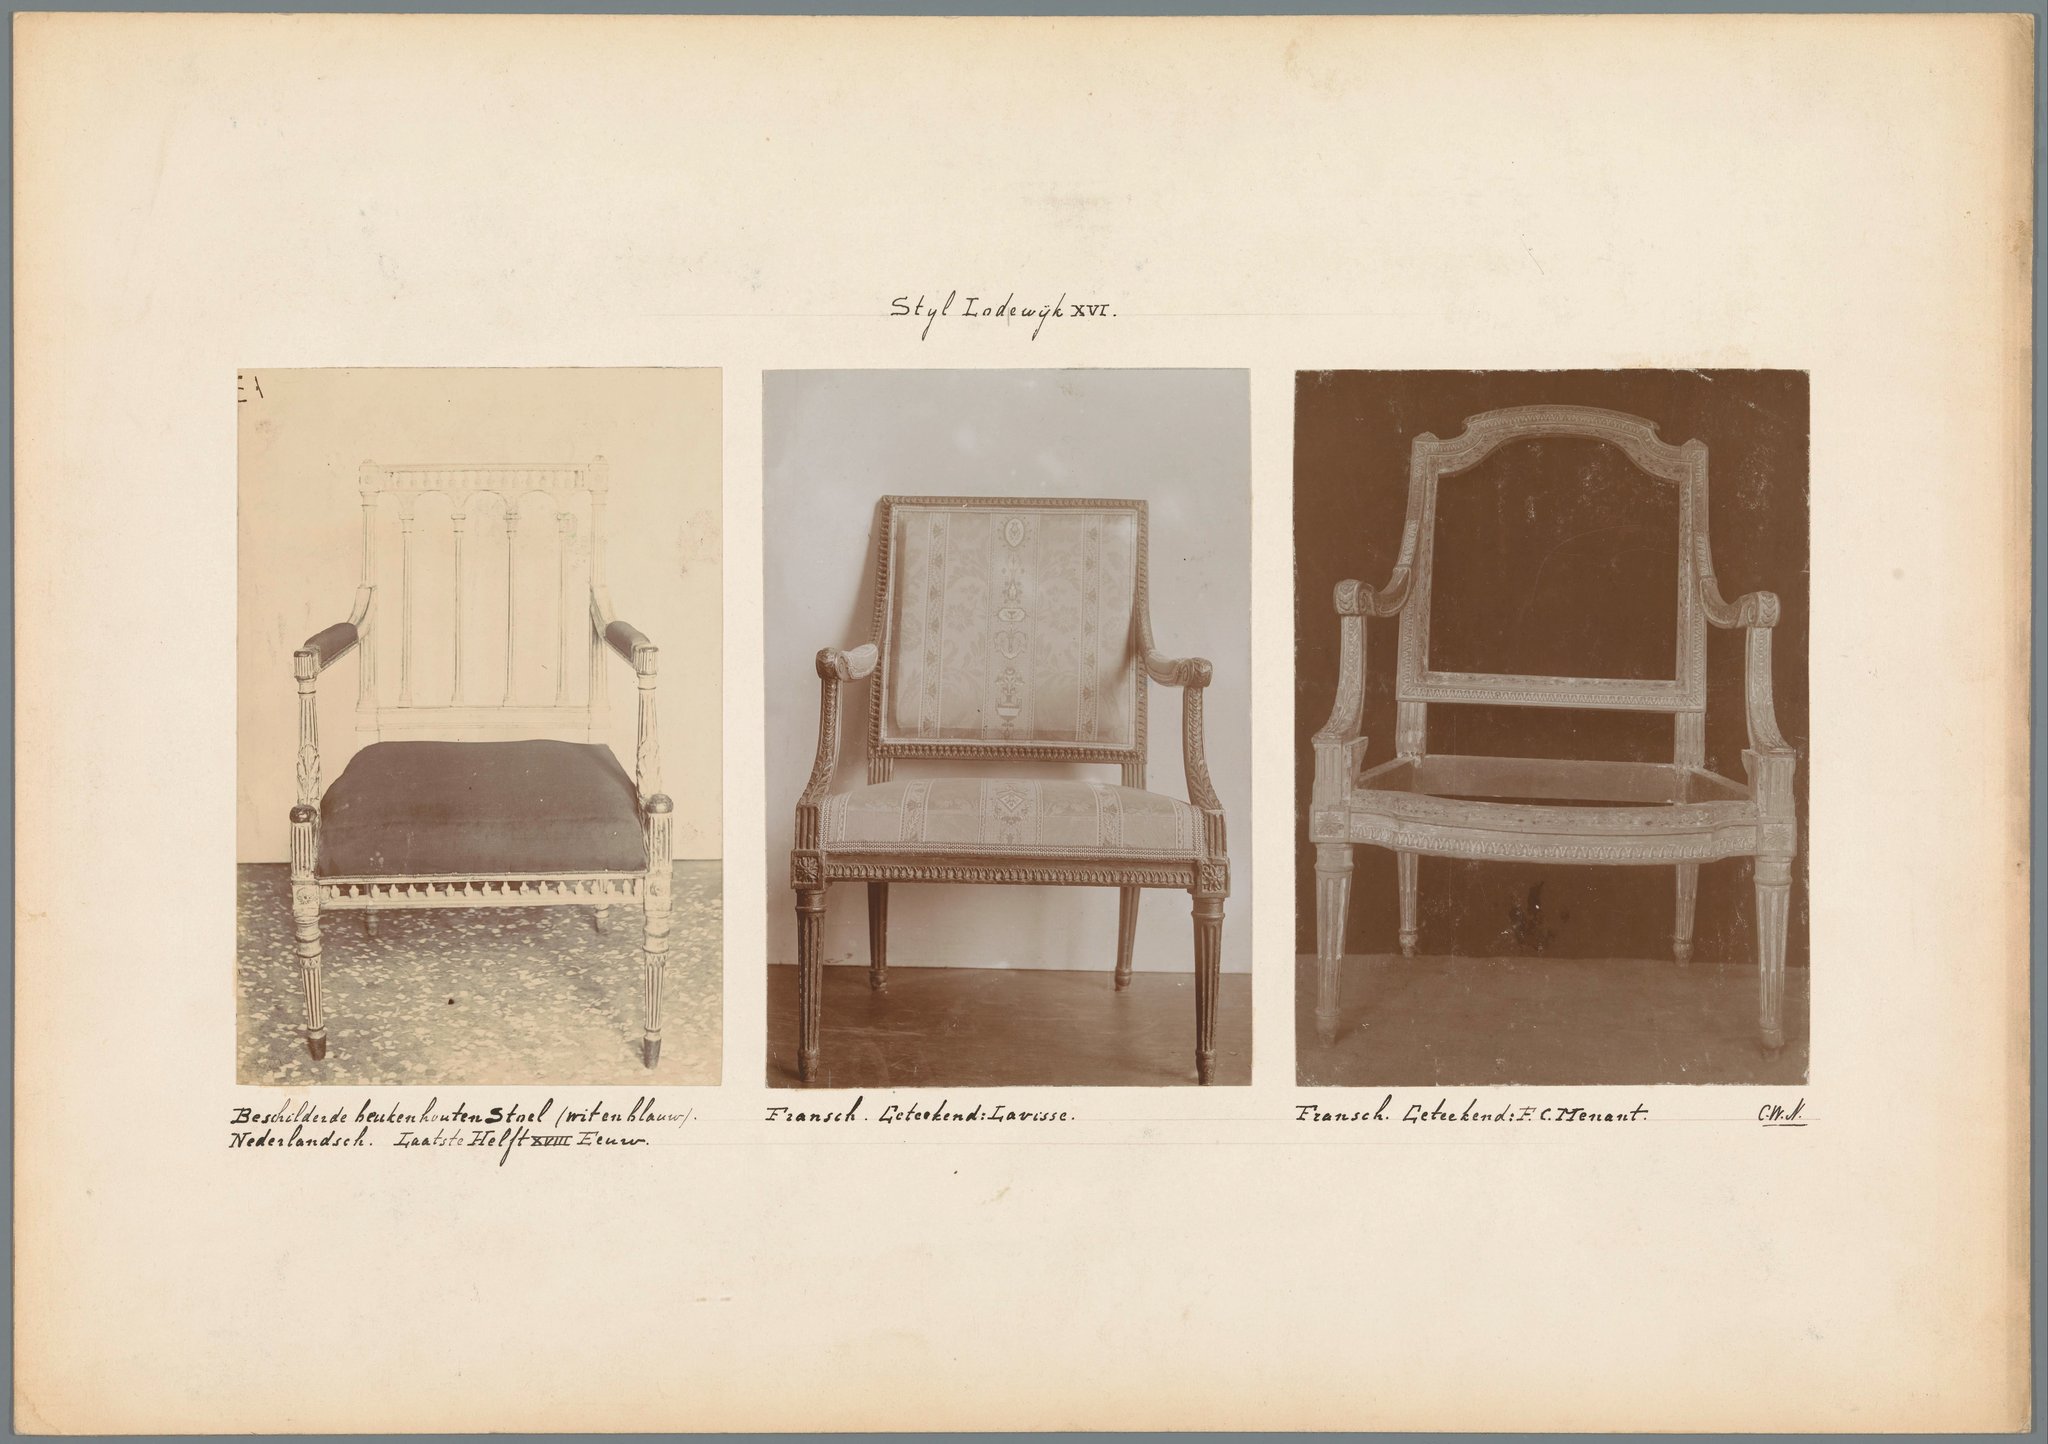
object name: photograph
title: Drie armstoelen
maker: Anonymous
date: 1875-1900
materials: cardboard, photographic support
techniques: collodion silver print, gelatin silver print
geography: europe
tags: armchair, seat, europe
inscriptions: inscription: ‘Stijl Lodewijk XVI.’, collector's mark: ‘INSTITUUT VOOR KUNST-NIJVERHEIDSONDERWIJS GABRIËL METSUSTRAAT No. 16 AMSTERDAM’, collector's mark: ‘KUNSTNIJVERHEIDSCHOOL QUELLINUS AMSTERDAM FRANS HALSSTRAAT 14.’, inscription: ‘C.W.N.’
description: Links een armstoel met een open rug met spijlen, midden een armstoel gedecoreerd met bloemen en voluten aan de armleggers, rechts een armstoel zonder bekleding, gedecoreerd met bloemen en voluten aan de armleggers.